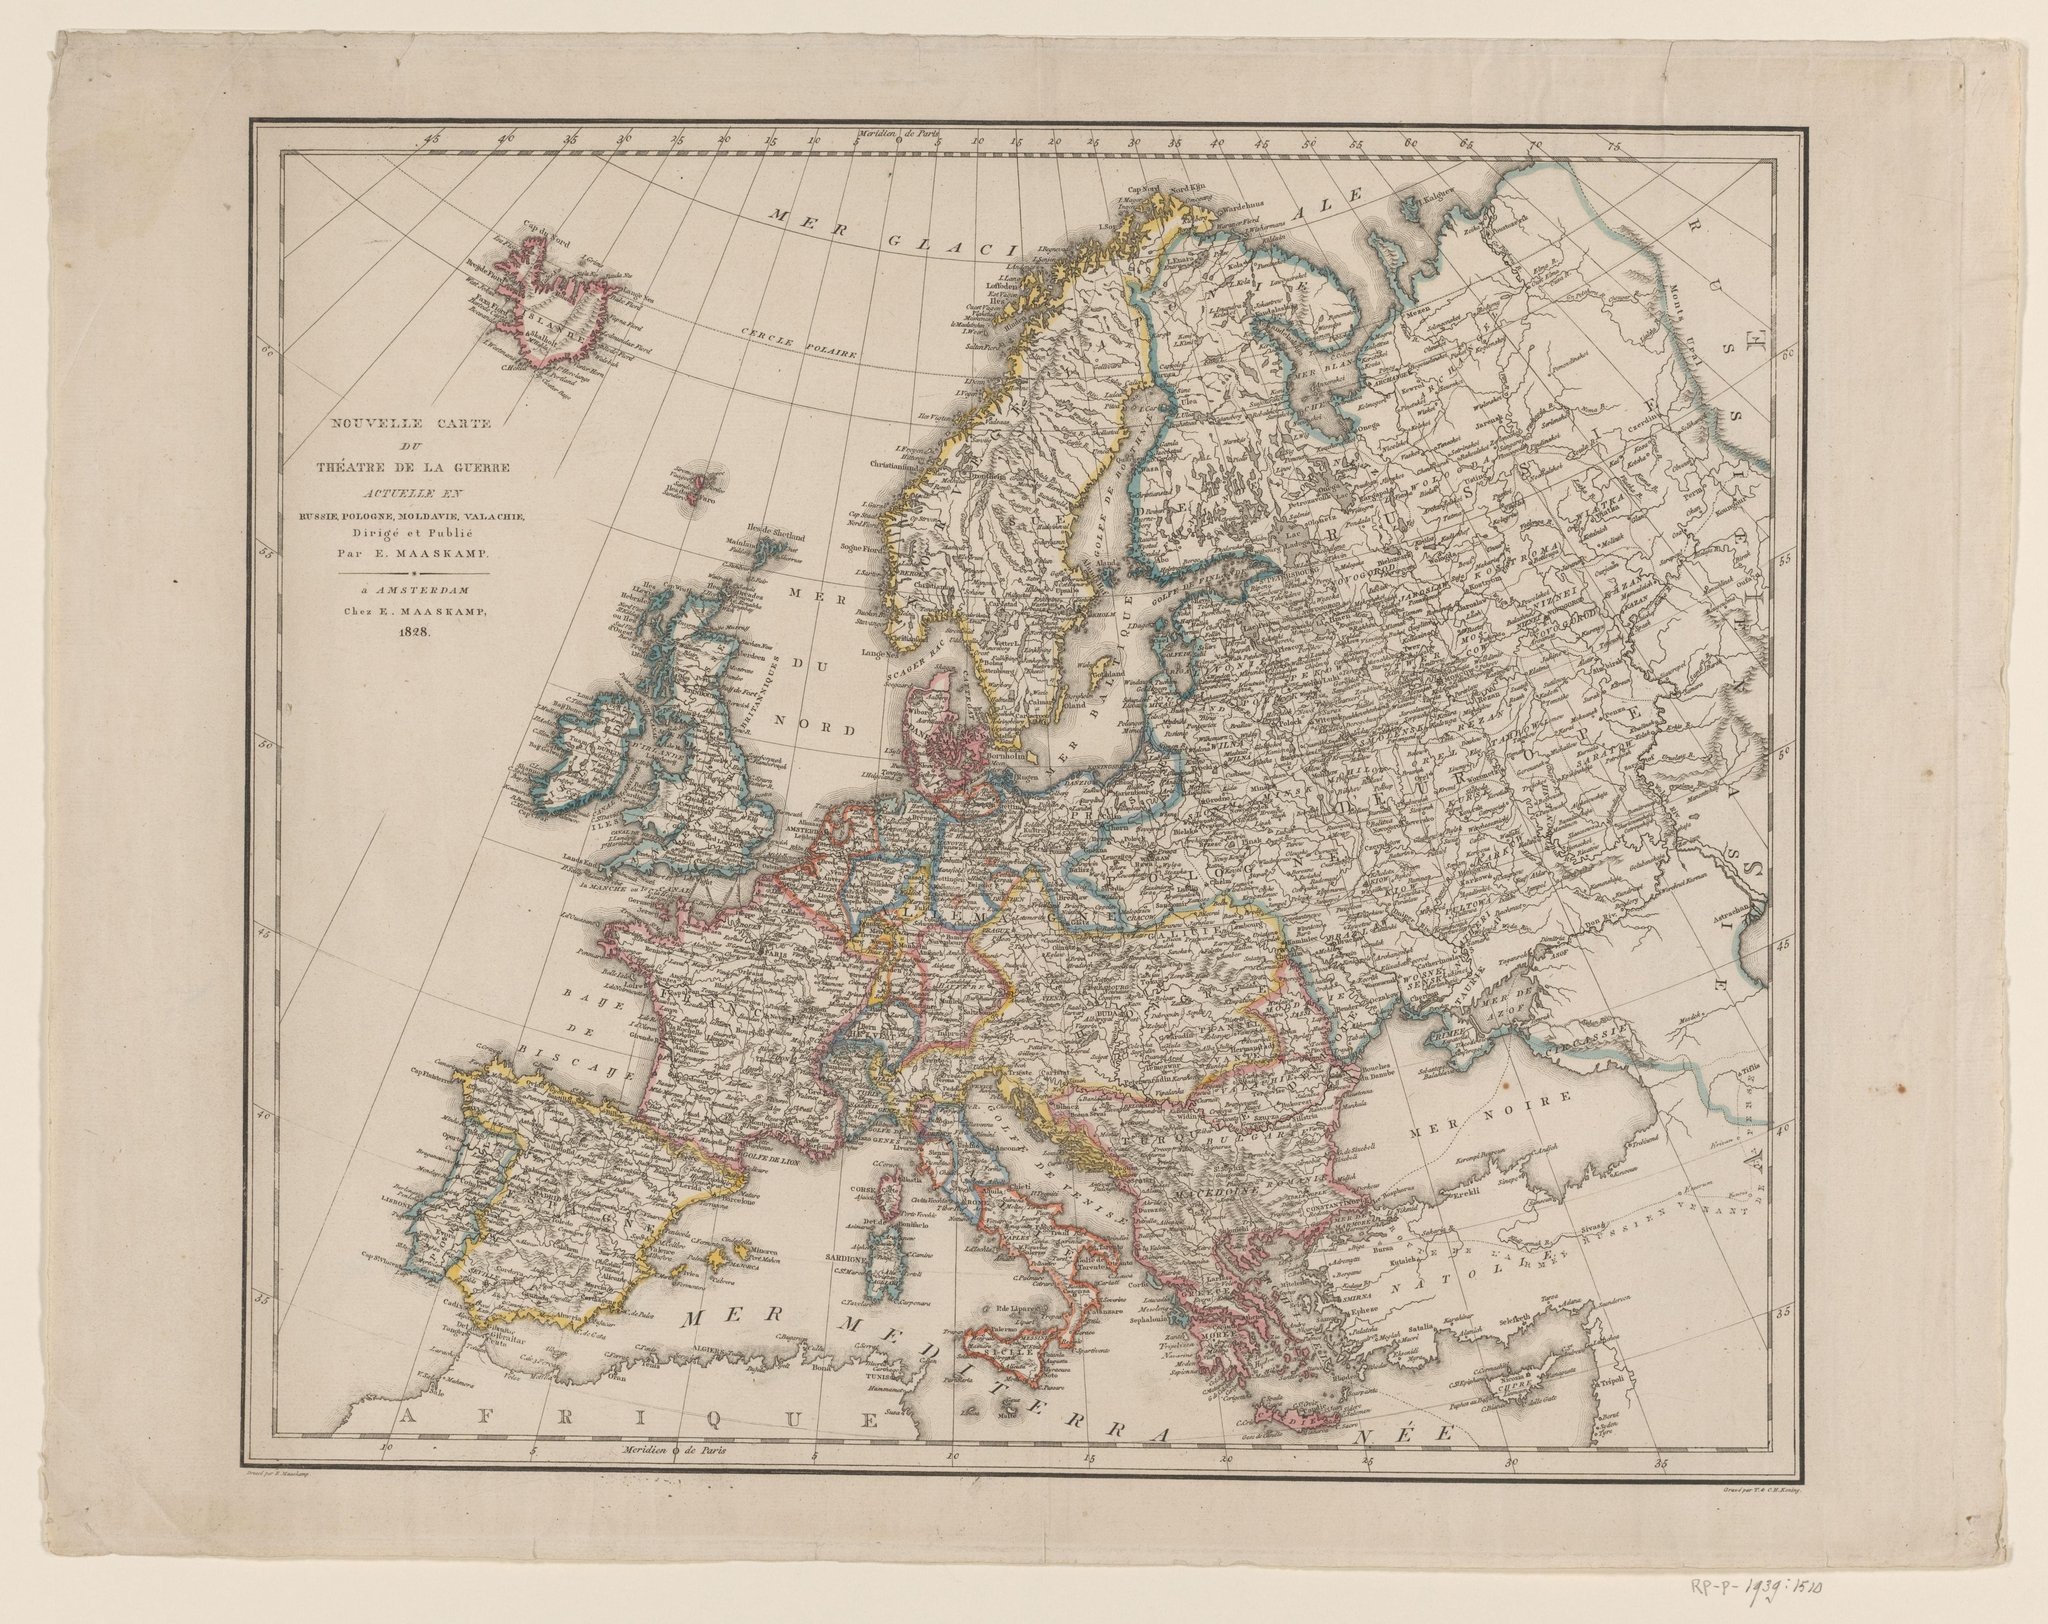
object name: print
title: Nouvelle carte de théatre de la guerre actuelle en Russie, Pologne, Moldavie, Valachie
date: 1828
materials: paper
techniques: engraving, hand coloring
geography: amsterdam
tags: maps, atlases, europe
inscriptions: collector's mark: Lugt 2166, collector's mark: Lugt 2760